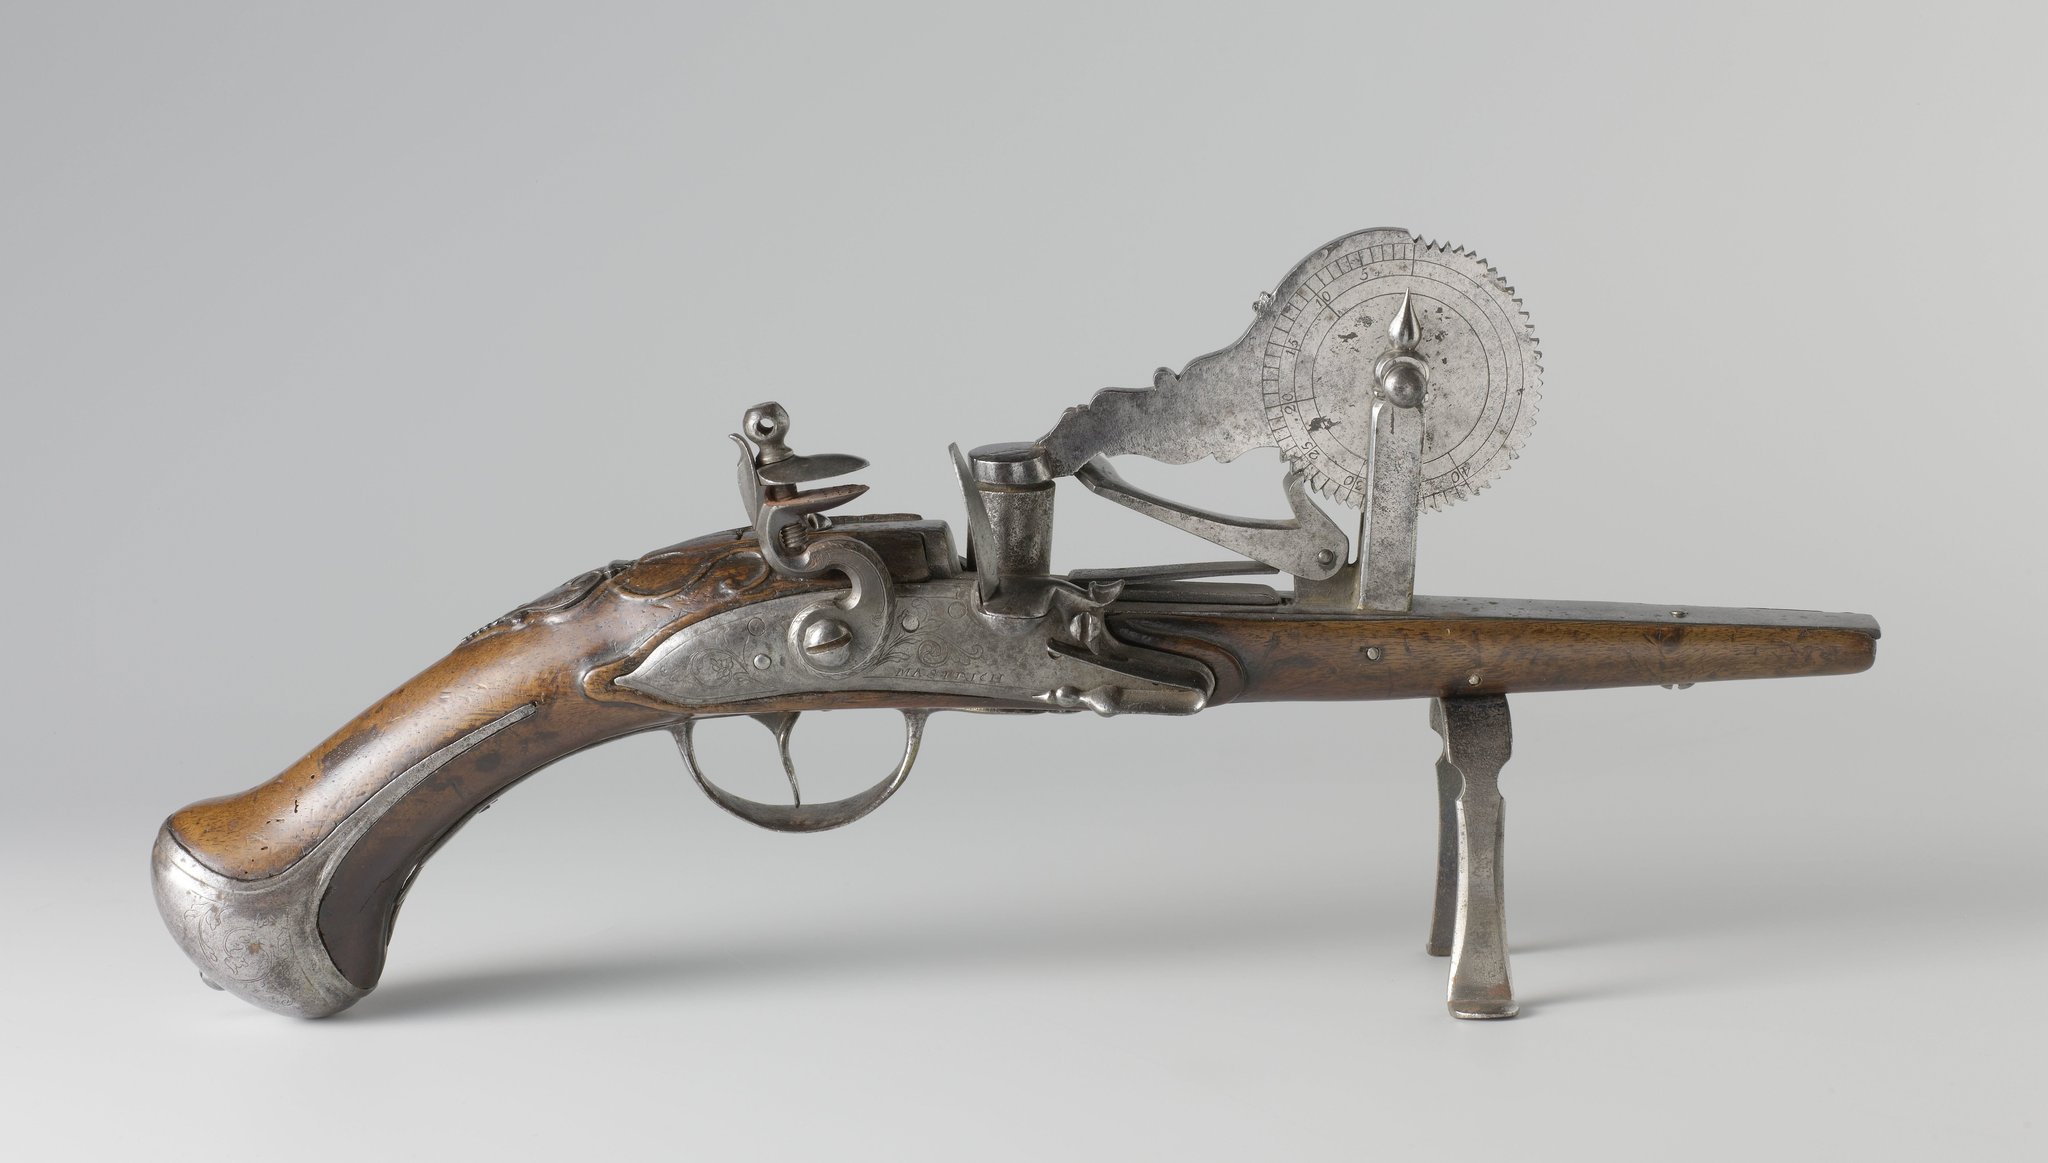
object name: powder tester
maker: Anonymous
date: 1700-1705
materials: iron, wood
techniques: cutting, embroidery, engraving, relief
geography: maastricht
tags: maastricht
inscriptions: inscription: ‘MASTRICH’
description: Gunpowder quality determined the reliability of a weapon. Powder was initially tested by eye or by tasting it. Over time various kinds of powder testers were developed in which exact amounts of gunpowder would be ignited. The result shown on the wheel of this example indicates the force and therefore the quality of the powder.